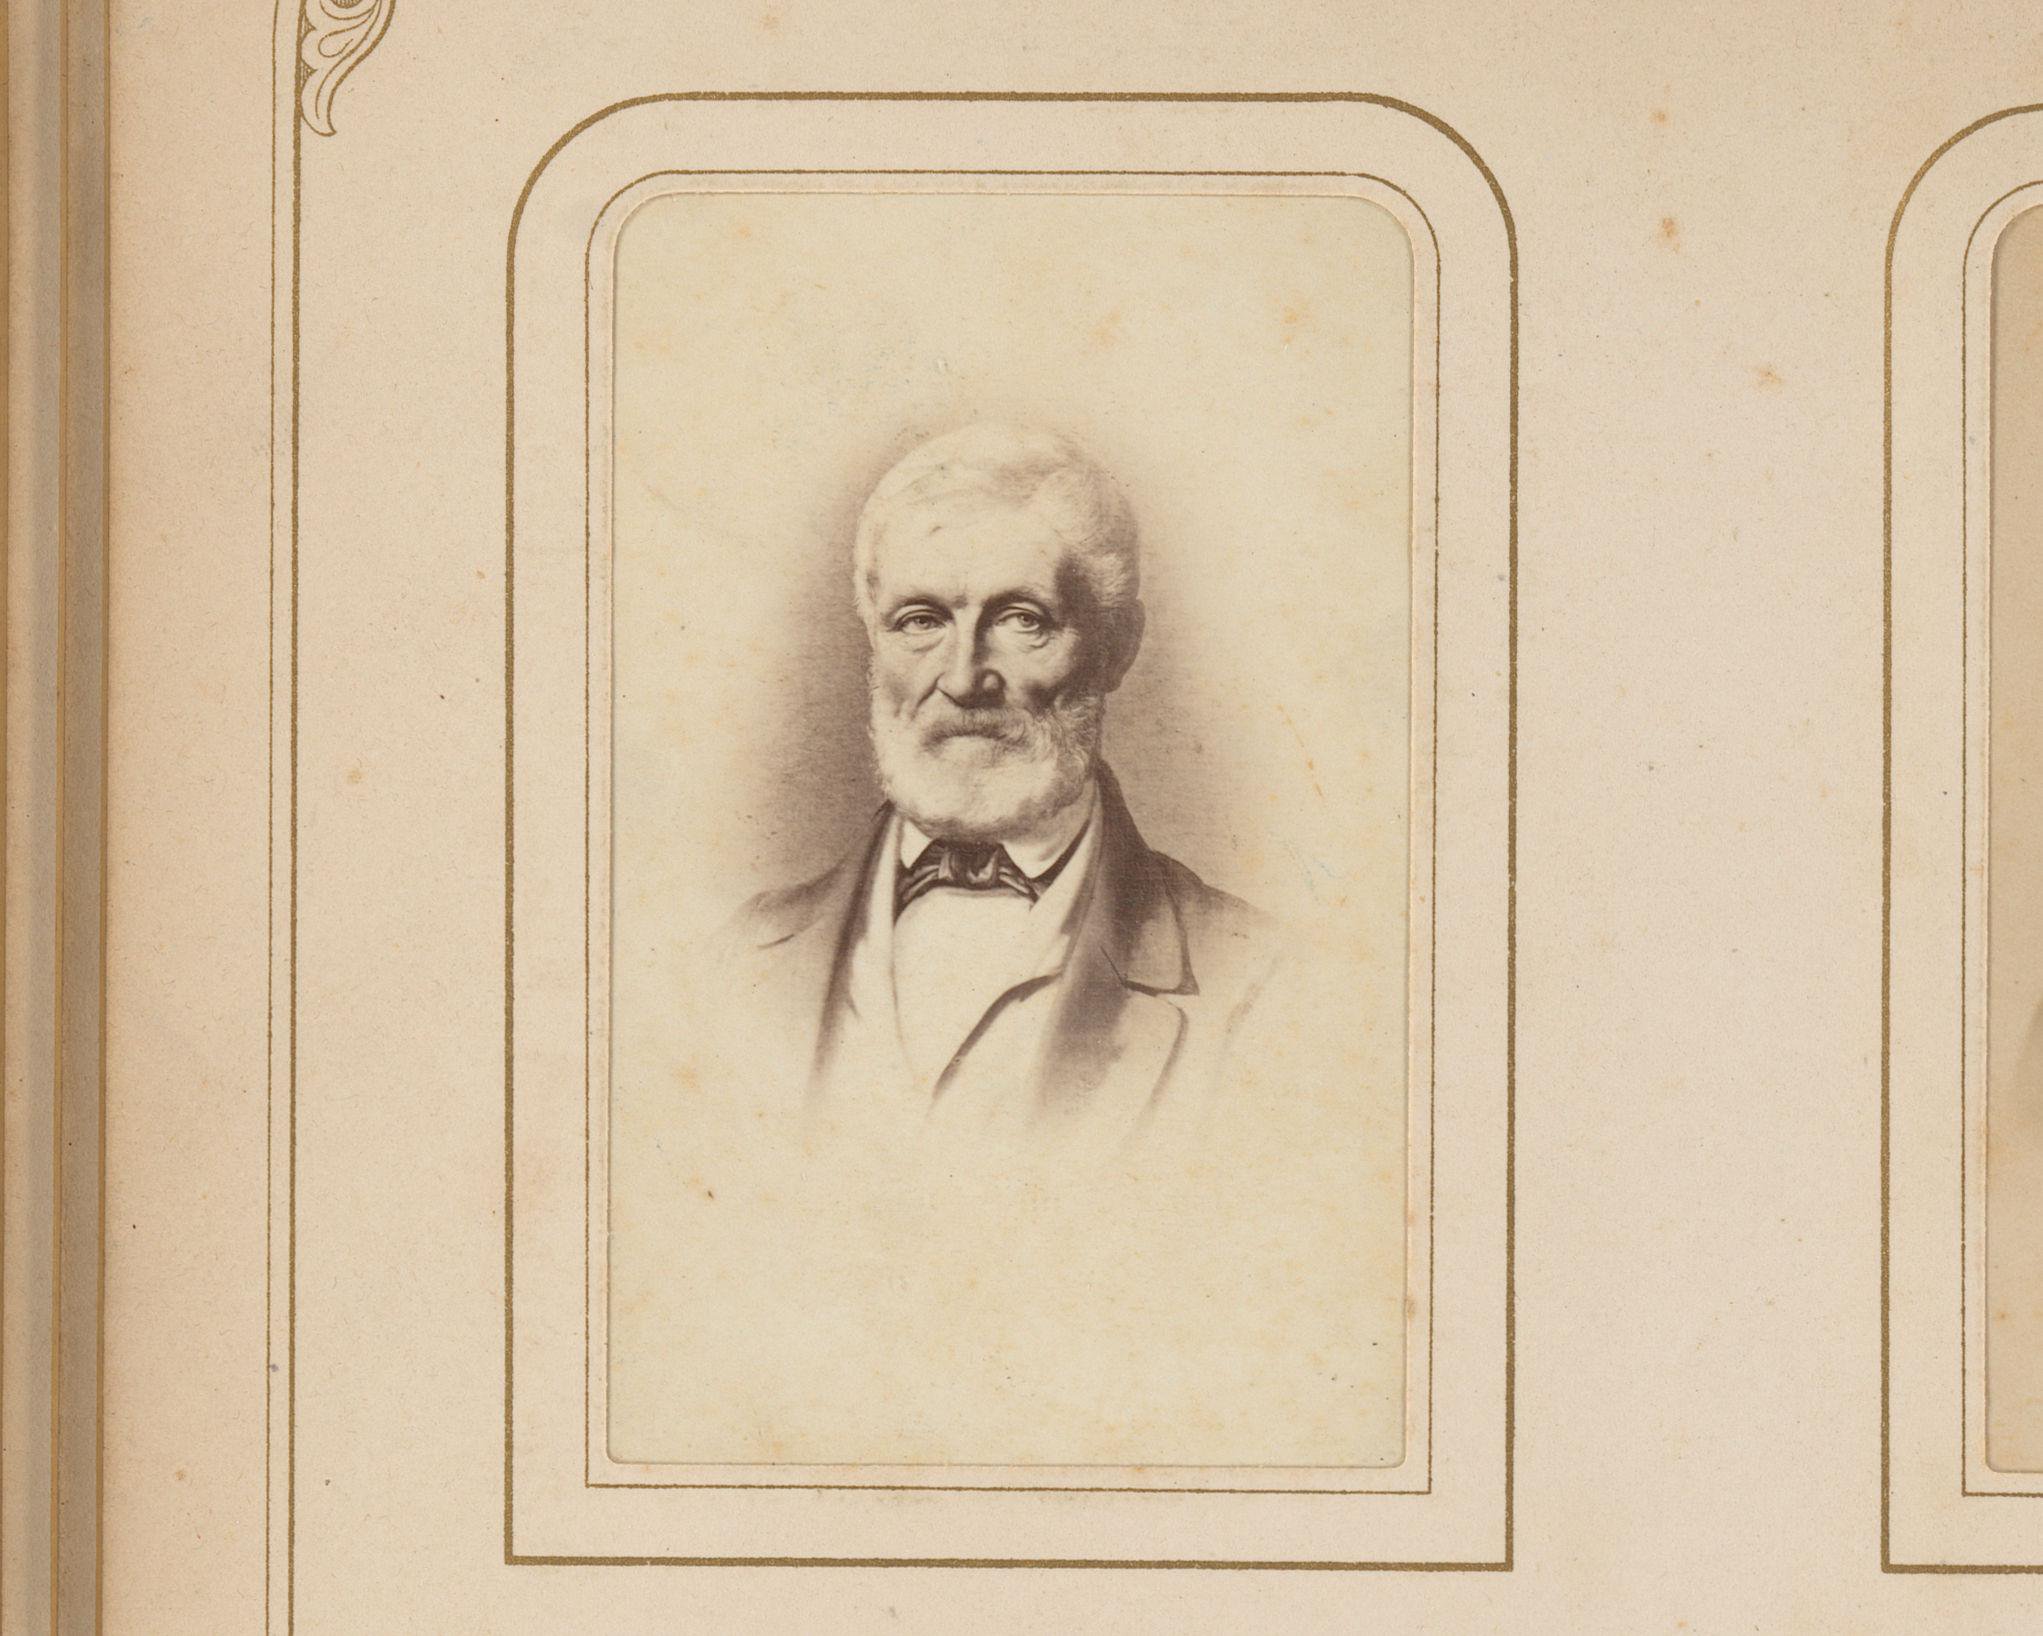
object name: reproduction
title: Fotoreproductie van een getekend portret van een man met baard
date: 1860-1890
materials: cardboard, photographic support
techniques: albumen print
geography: amsterdam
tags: historical persons, beard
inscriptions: inscription: ‘PHOTOGRAPHIE DE/ H. PH. J. SCHUITEN/ SUCCr. J. P. OPPERS/ AMSTERDAM’